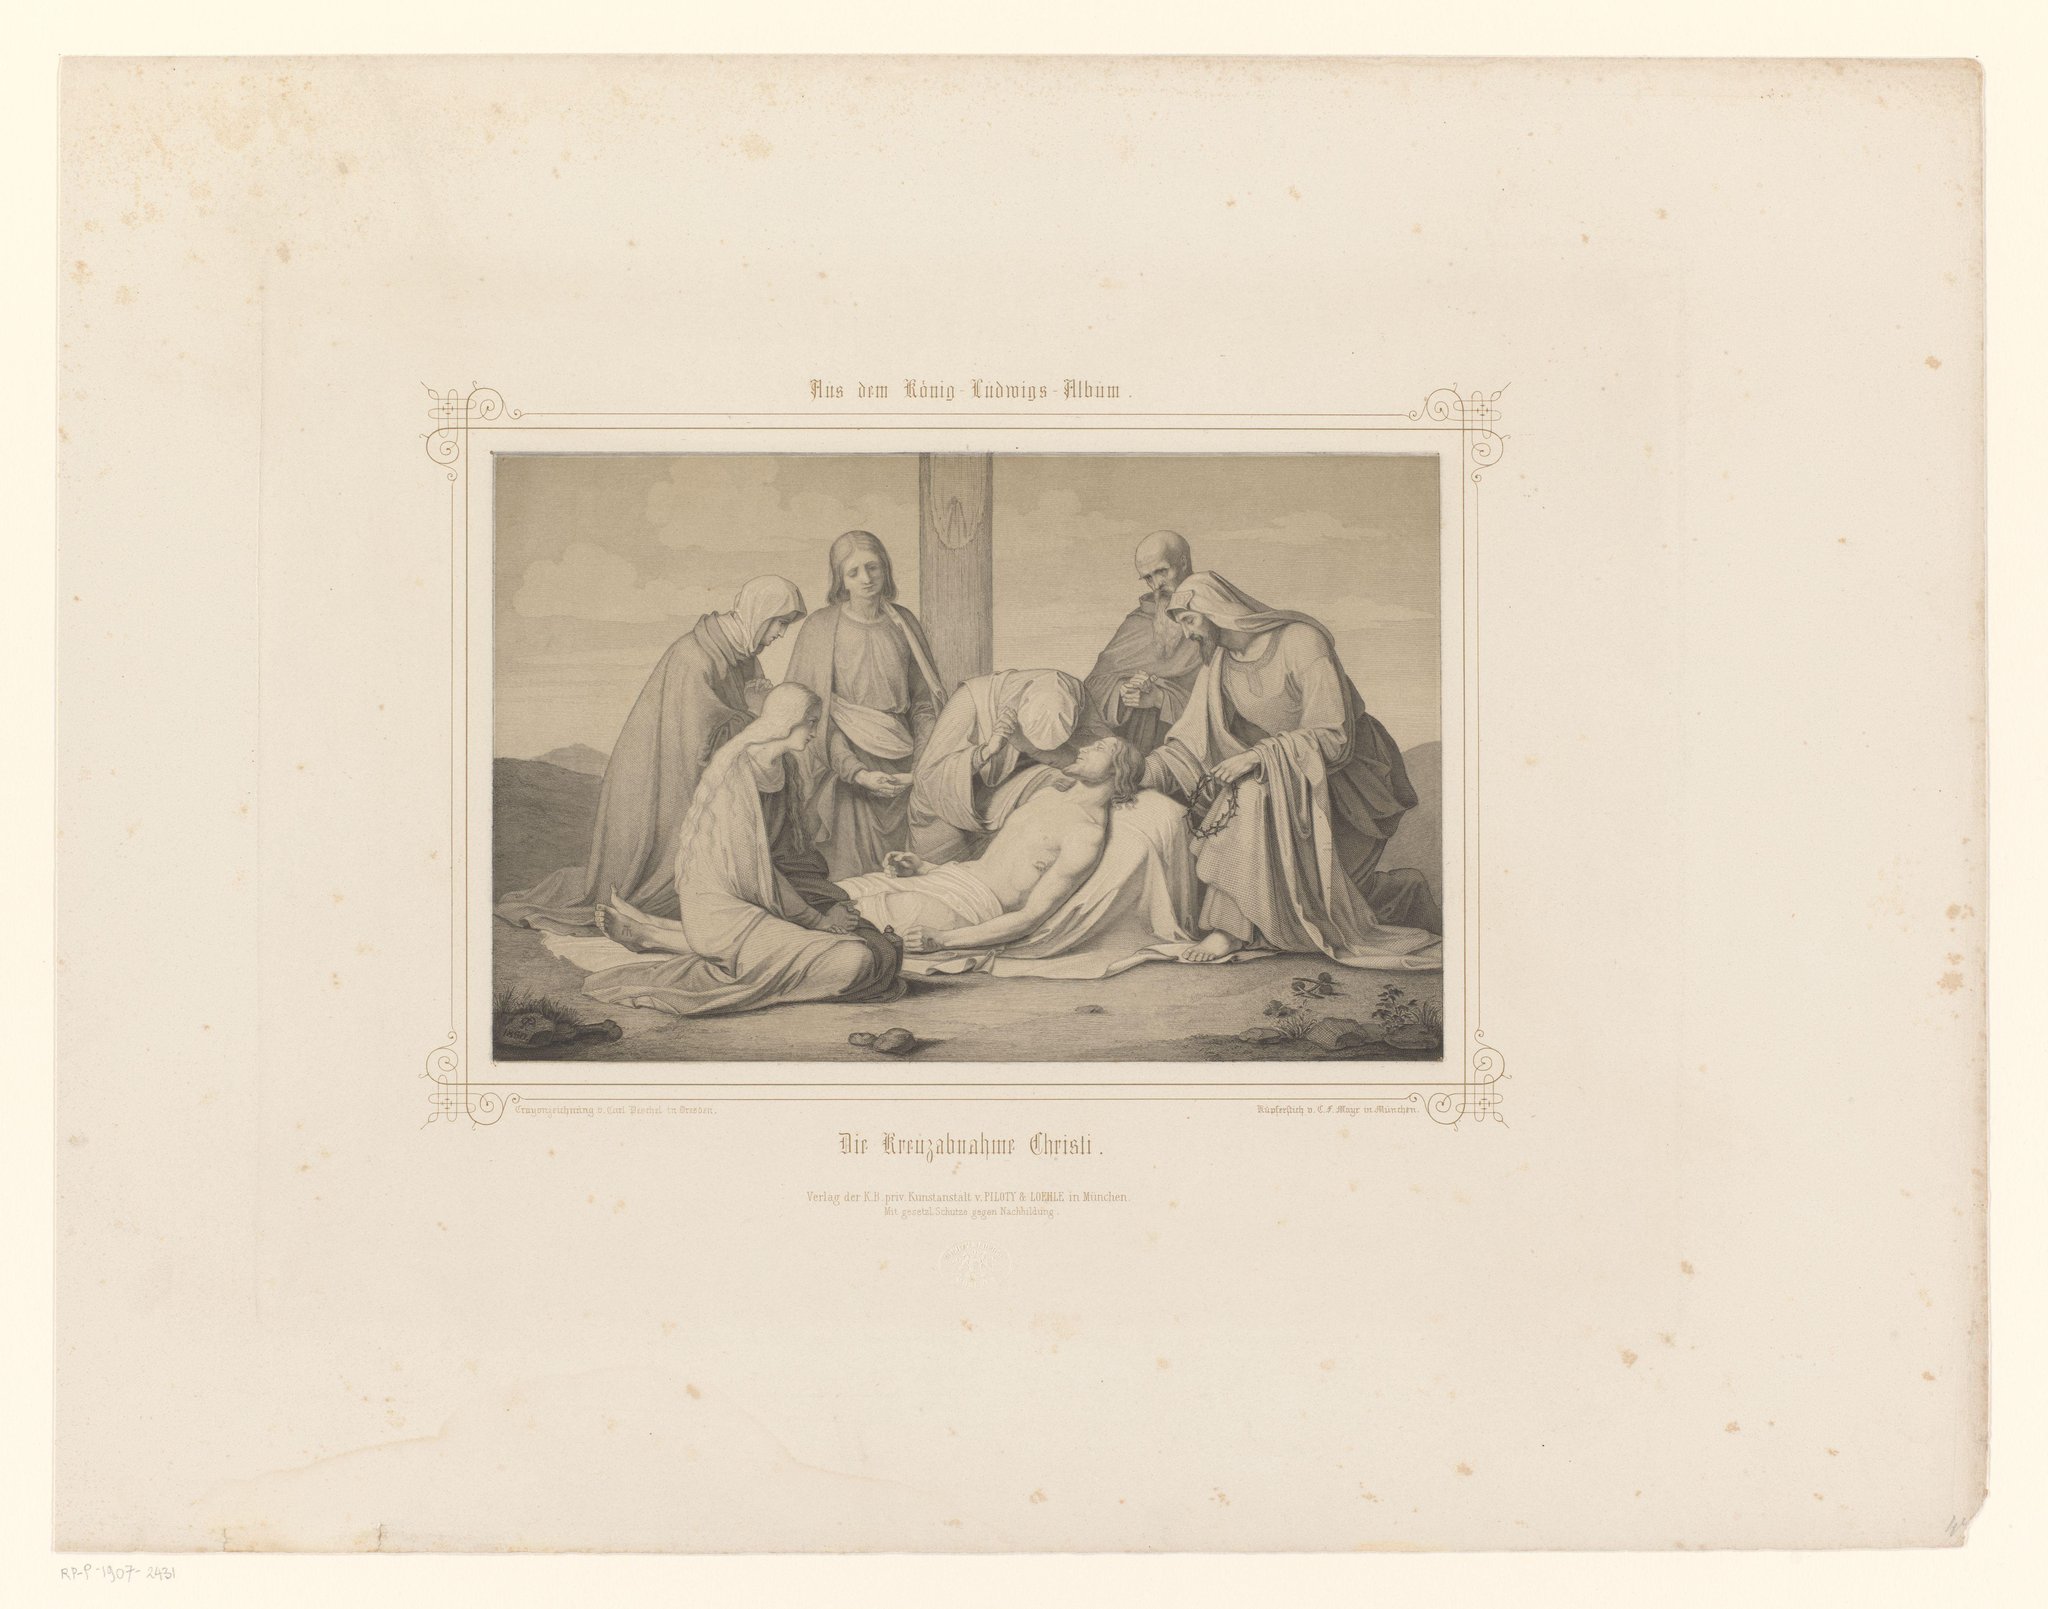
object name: print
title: Die Kreuzabnahme Christi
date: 1850-1859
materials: paper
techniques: engraving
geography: munich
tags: lodewijk i (koning van beieren), christ is laid down ~ descent from the cross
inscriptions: collector's mark: Lugt 2228, check stamp: ‘Piloty & Loehle Munchen’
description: Prent afkomstig uit de serie 'Album Seiner Majestät des Königs Ludwig I. von Bayern', verschenen in verschillende afleveringen. De prenten gaan terug op het album dat Lodewijk I van Beieren op 9 oktober 1850 kreeg overhandigd van verschillende kunstenaars.